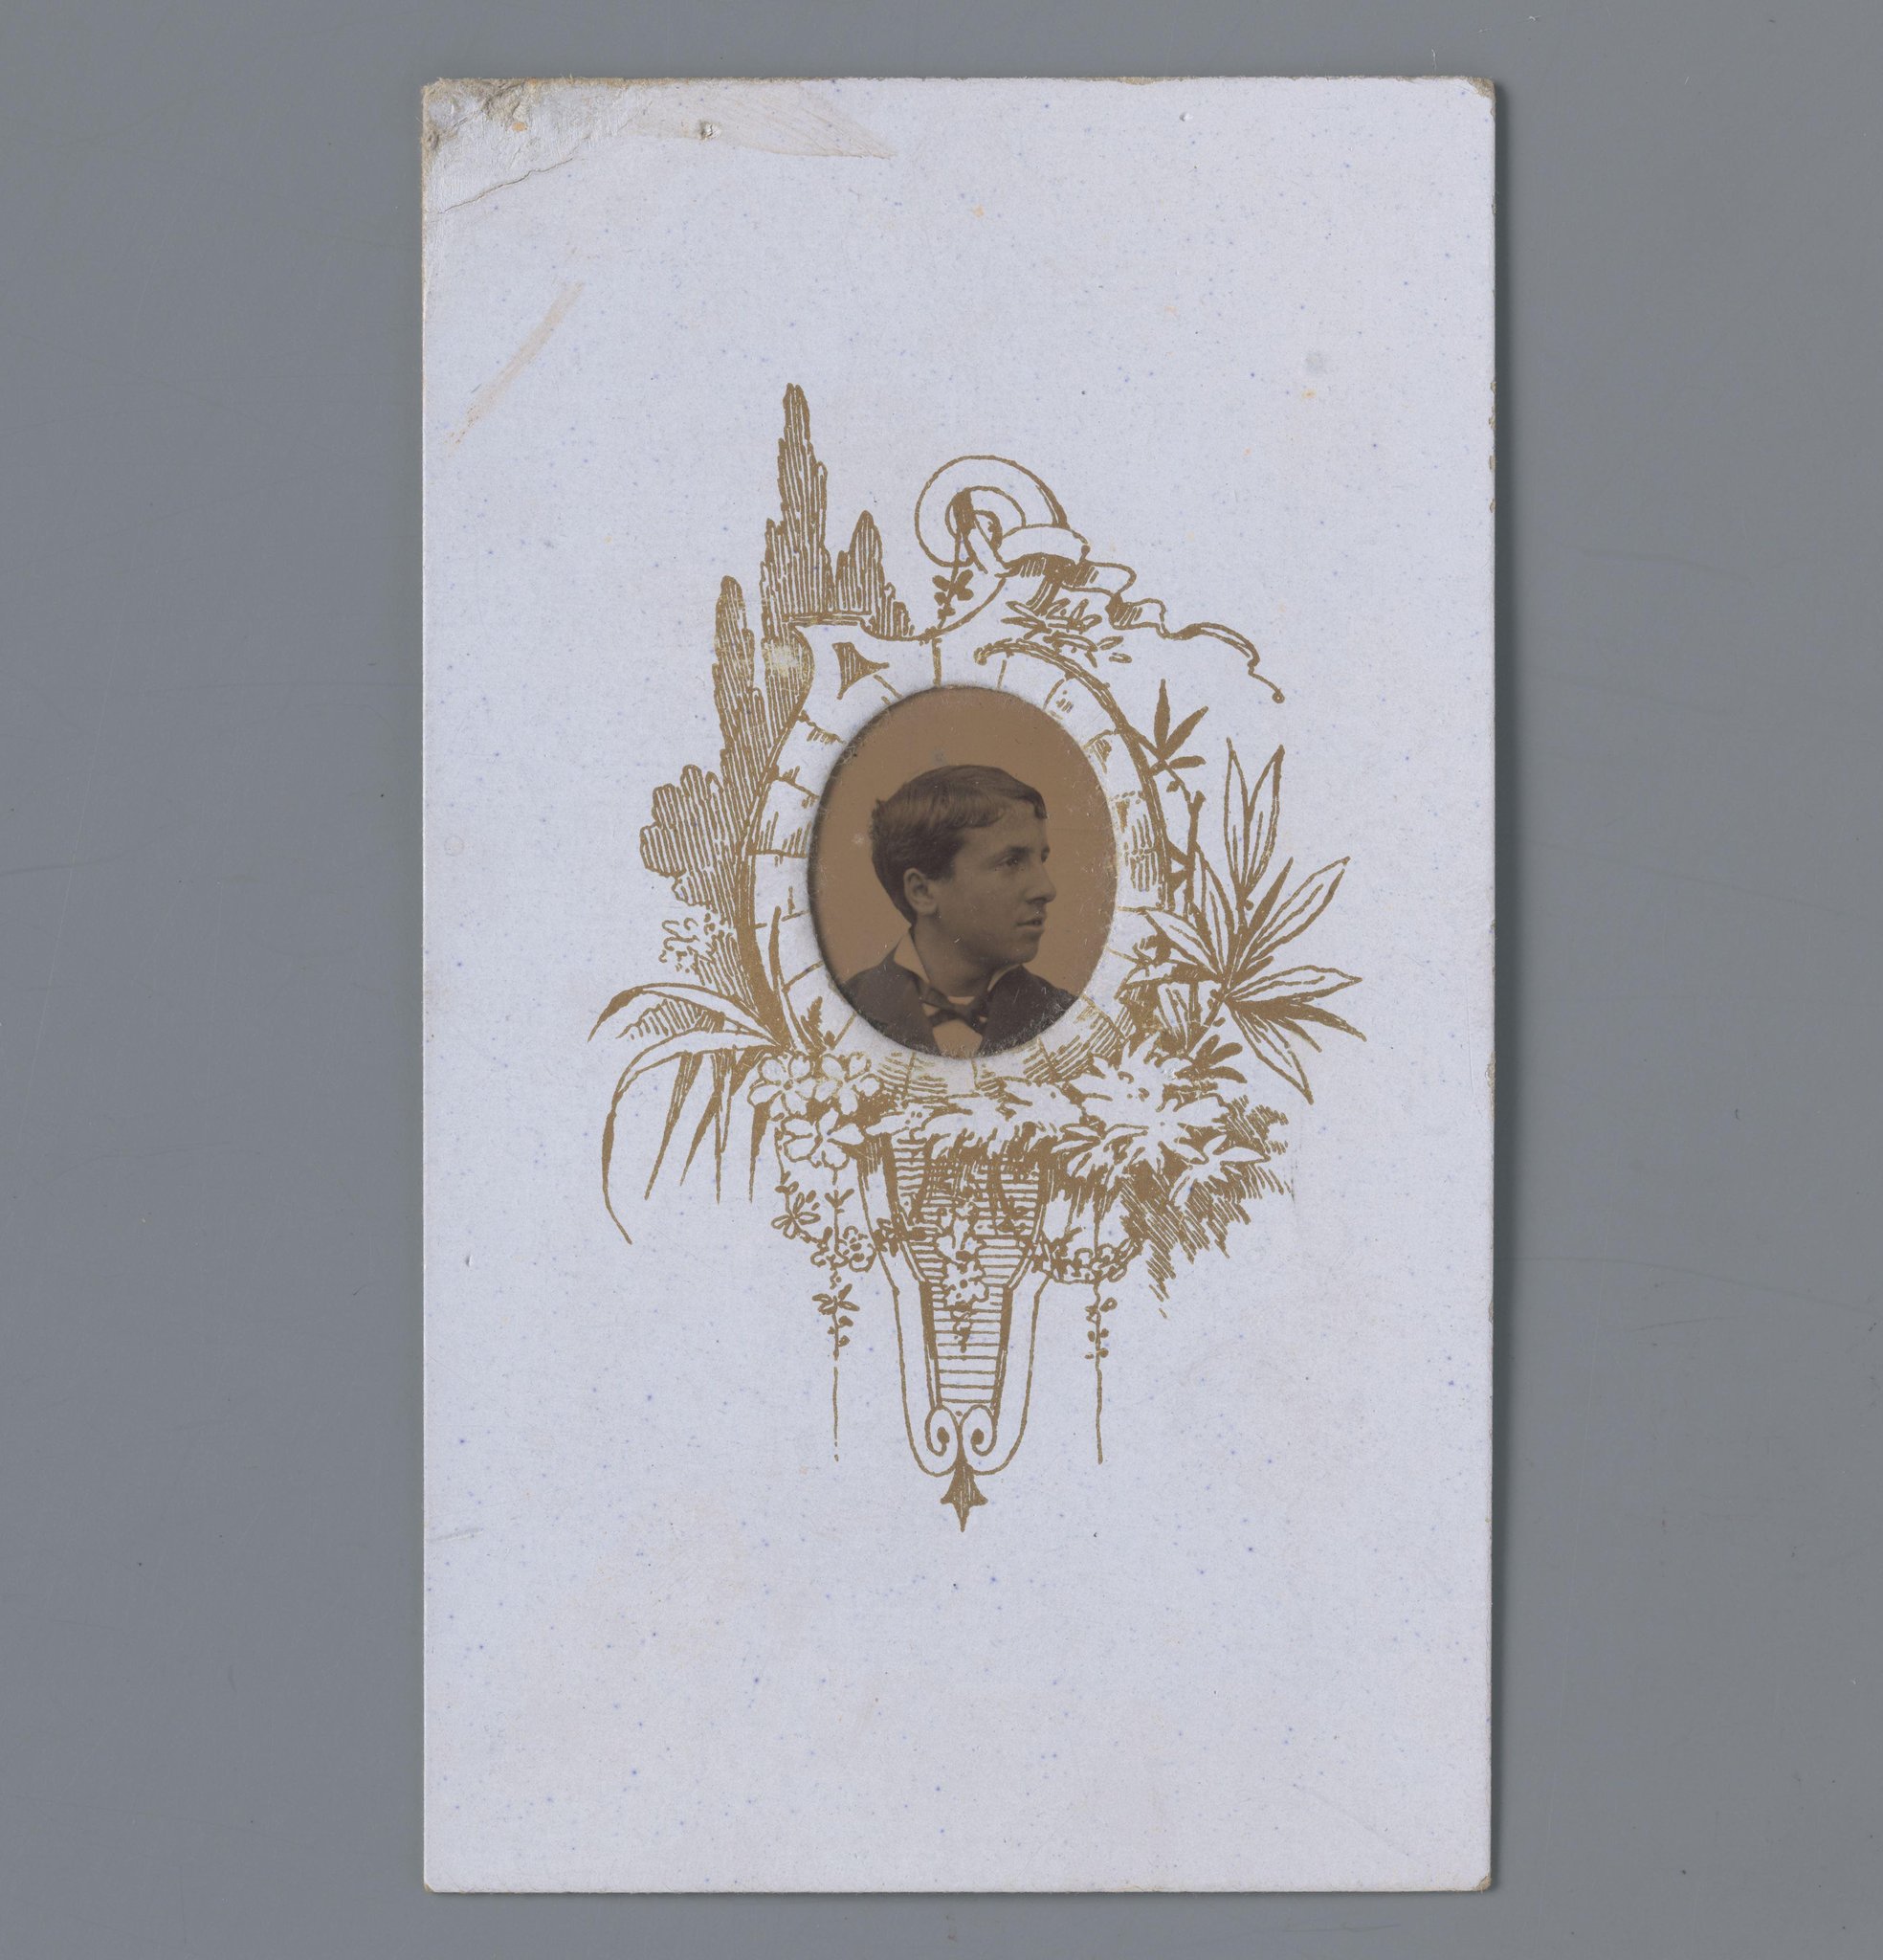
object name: photograph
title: Portret van een onbekende jongeman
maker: Anonymous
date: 1855-1900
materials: cardboard, iron, paper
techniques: ferrotyping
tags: historical persons